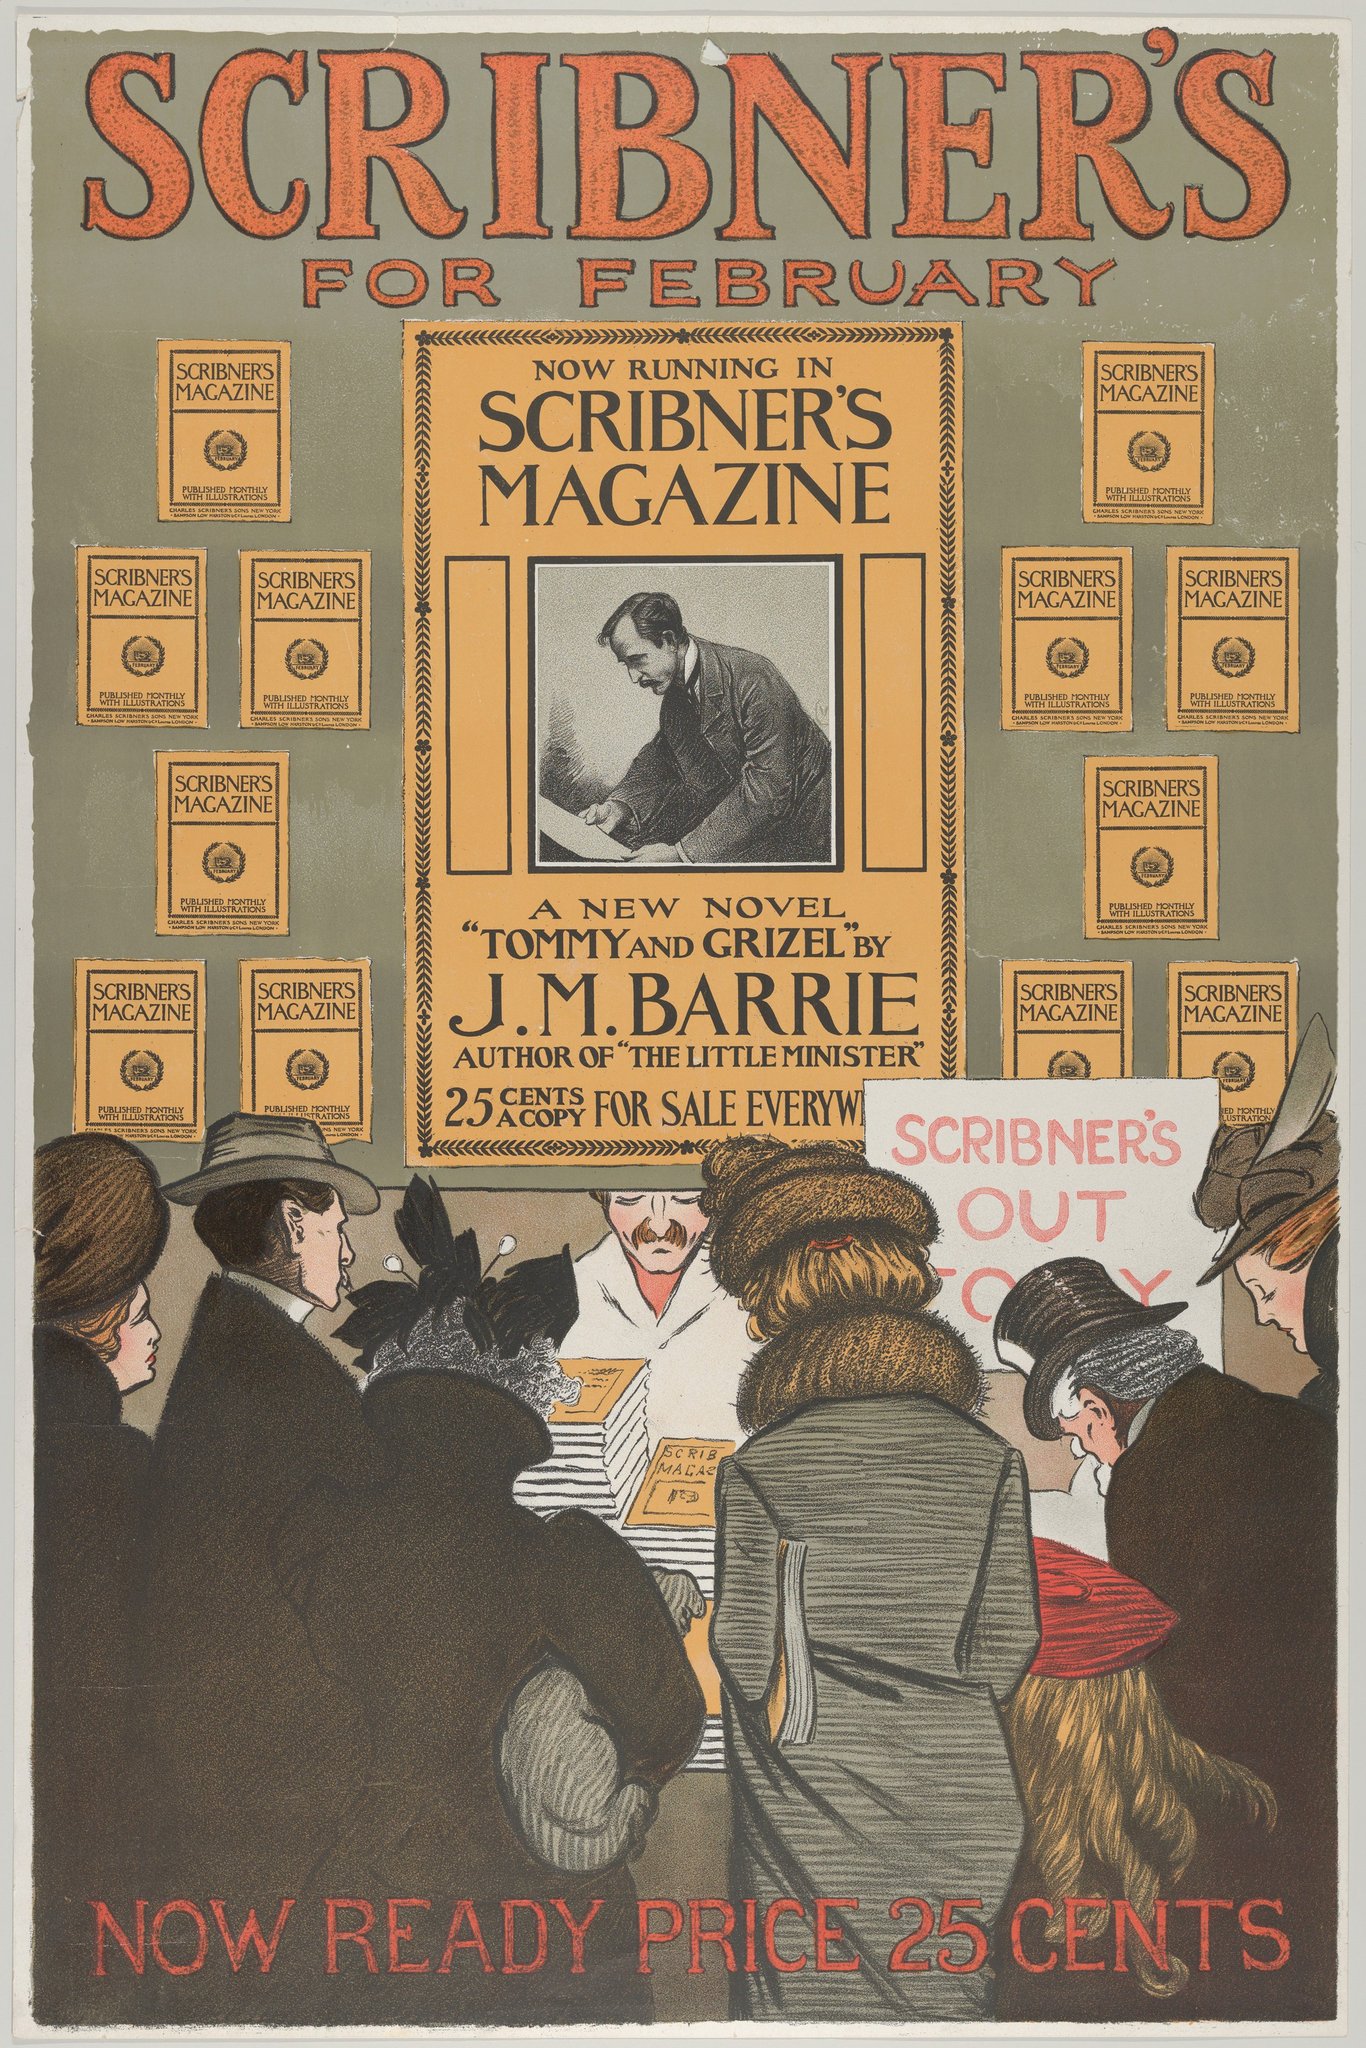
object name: print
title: Scribner's: "Tommy and Grizel" by J. M. Barrie, February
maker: anonymous, american, 20th century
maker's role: artist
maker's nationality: american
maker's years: 1900-1999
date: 1900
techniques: lithograph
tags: men,women